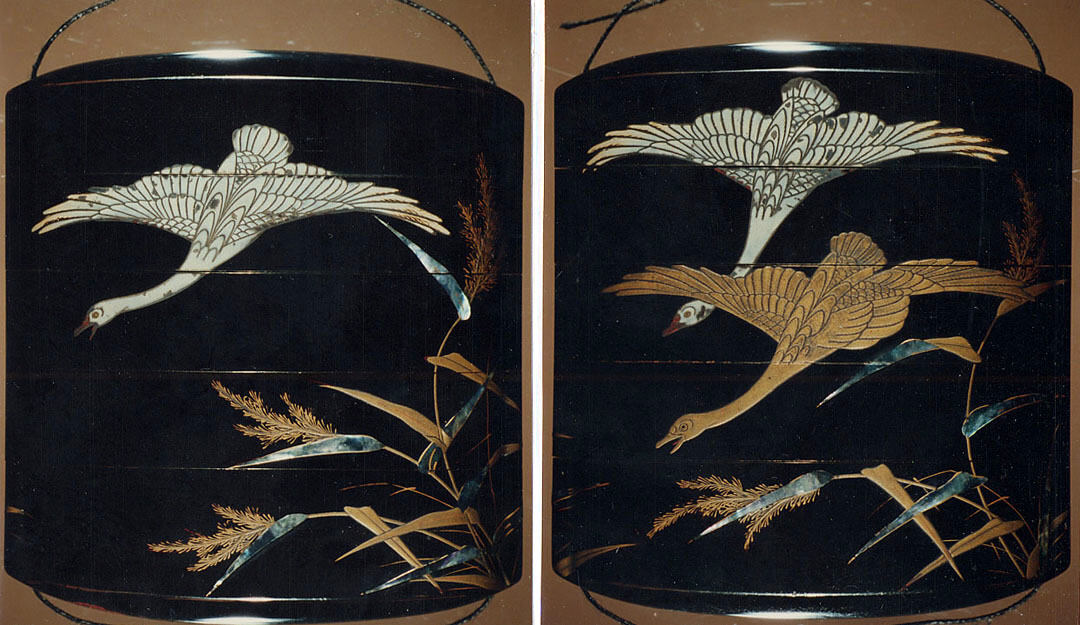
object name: inrō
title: Case (Inrō) with Design of Geese and Reeds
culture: japanese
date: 1701-1900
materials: gold, lacquer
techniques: fundame, hiramakie, roiro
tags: birds,plants